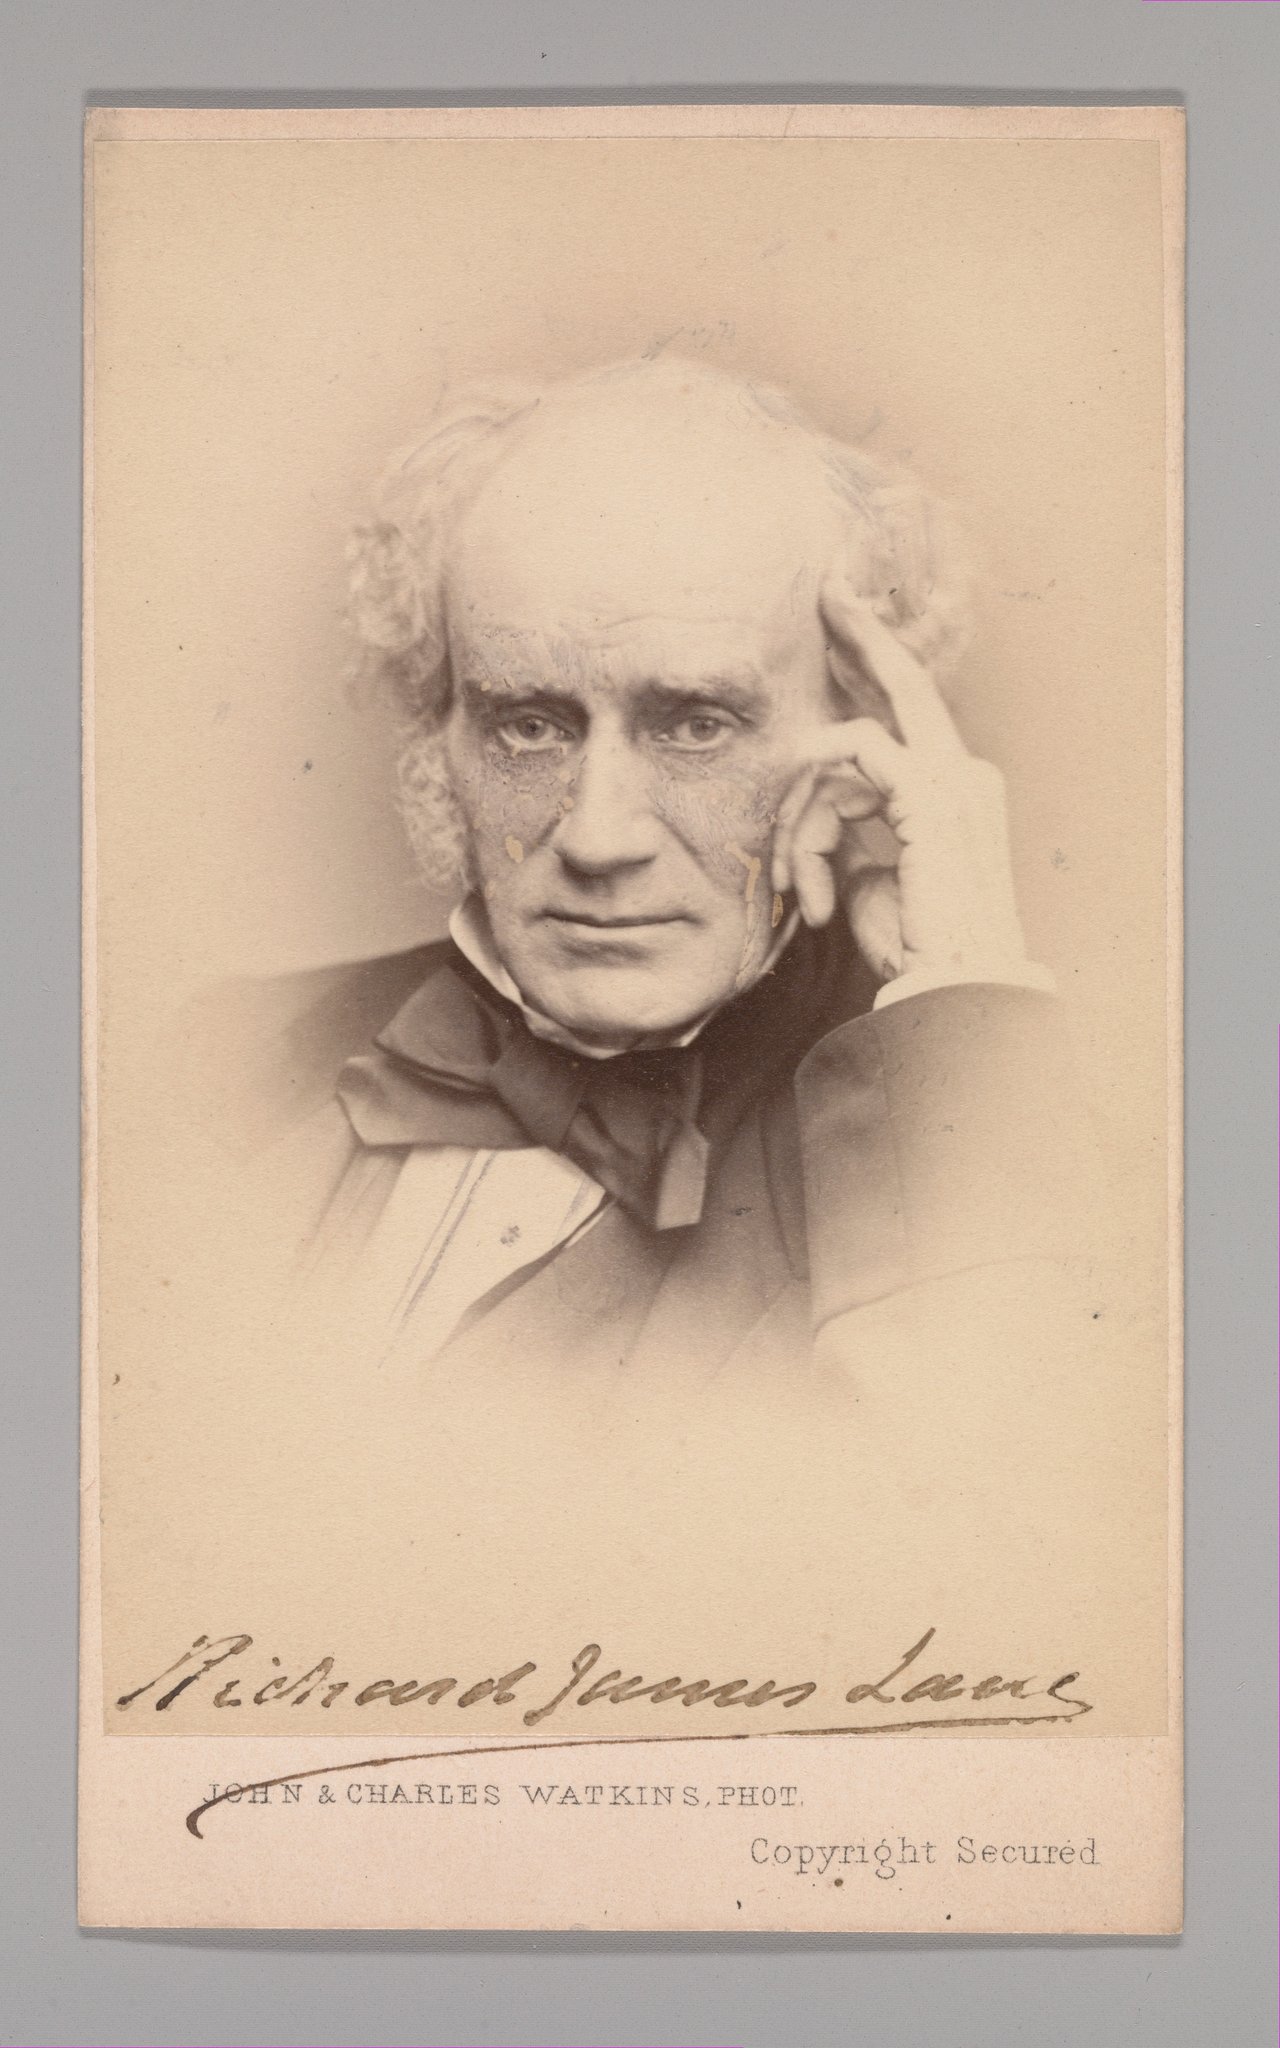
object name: carte de visite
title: [Richard James Lane]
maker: john and charles watkins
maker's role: photography studio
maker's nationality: british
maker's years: 1840-1875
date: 1860-1869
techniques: albumen silver print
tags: men,portraits